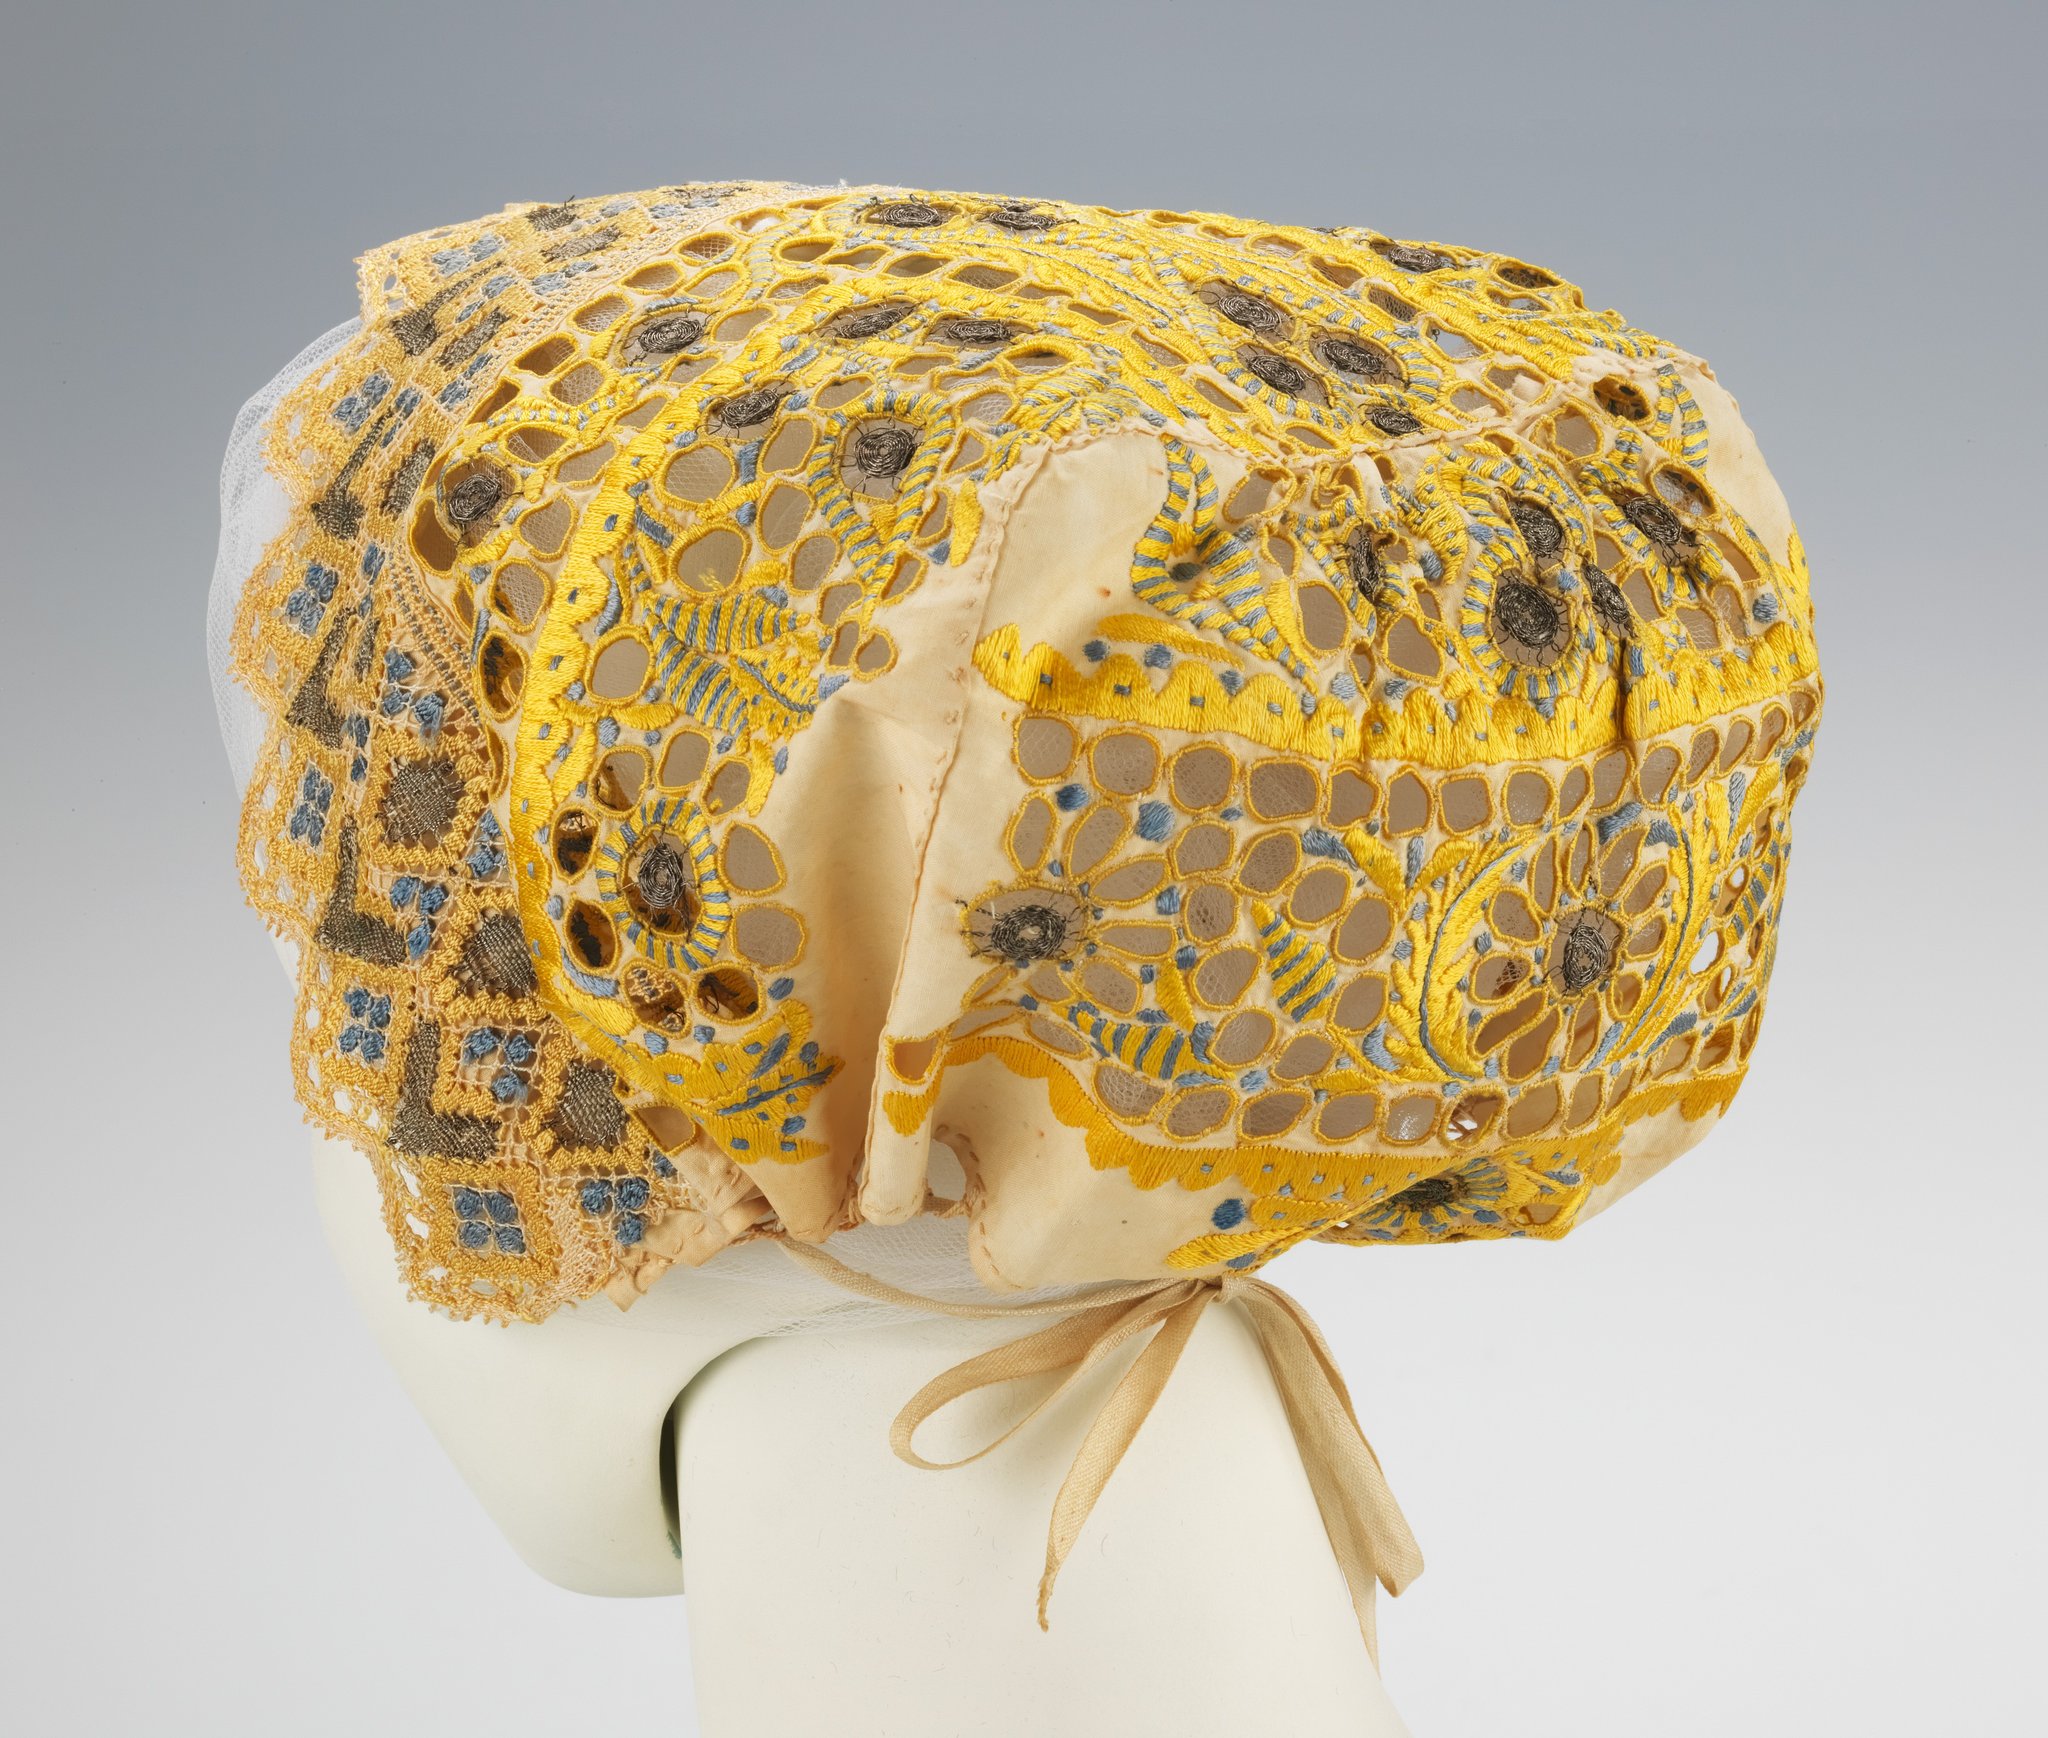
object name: cap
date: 1867-1900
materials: linen, metal, silk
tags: flowers